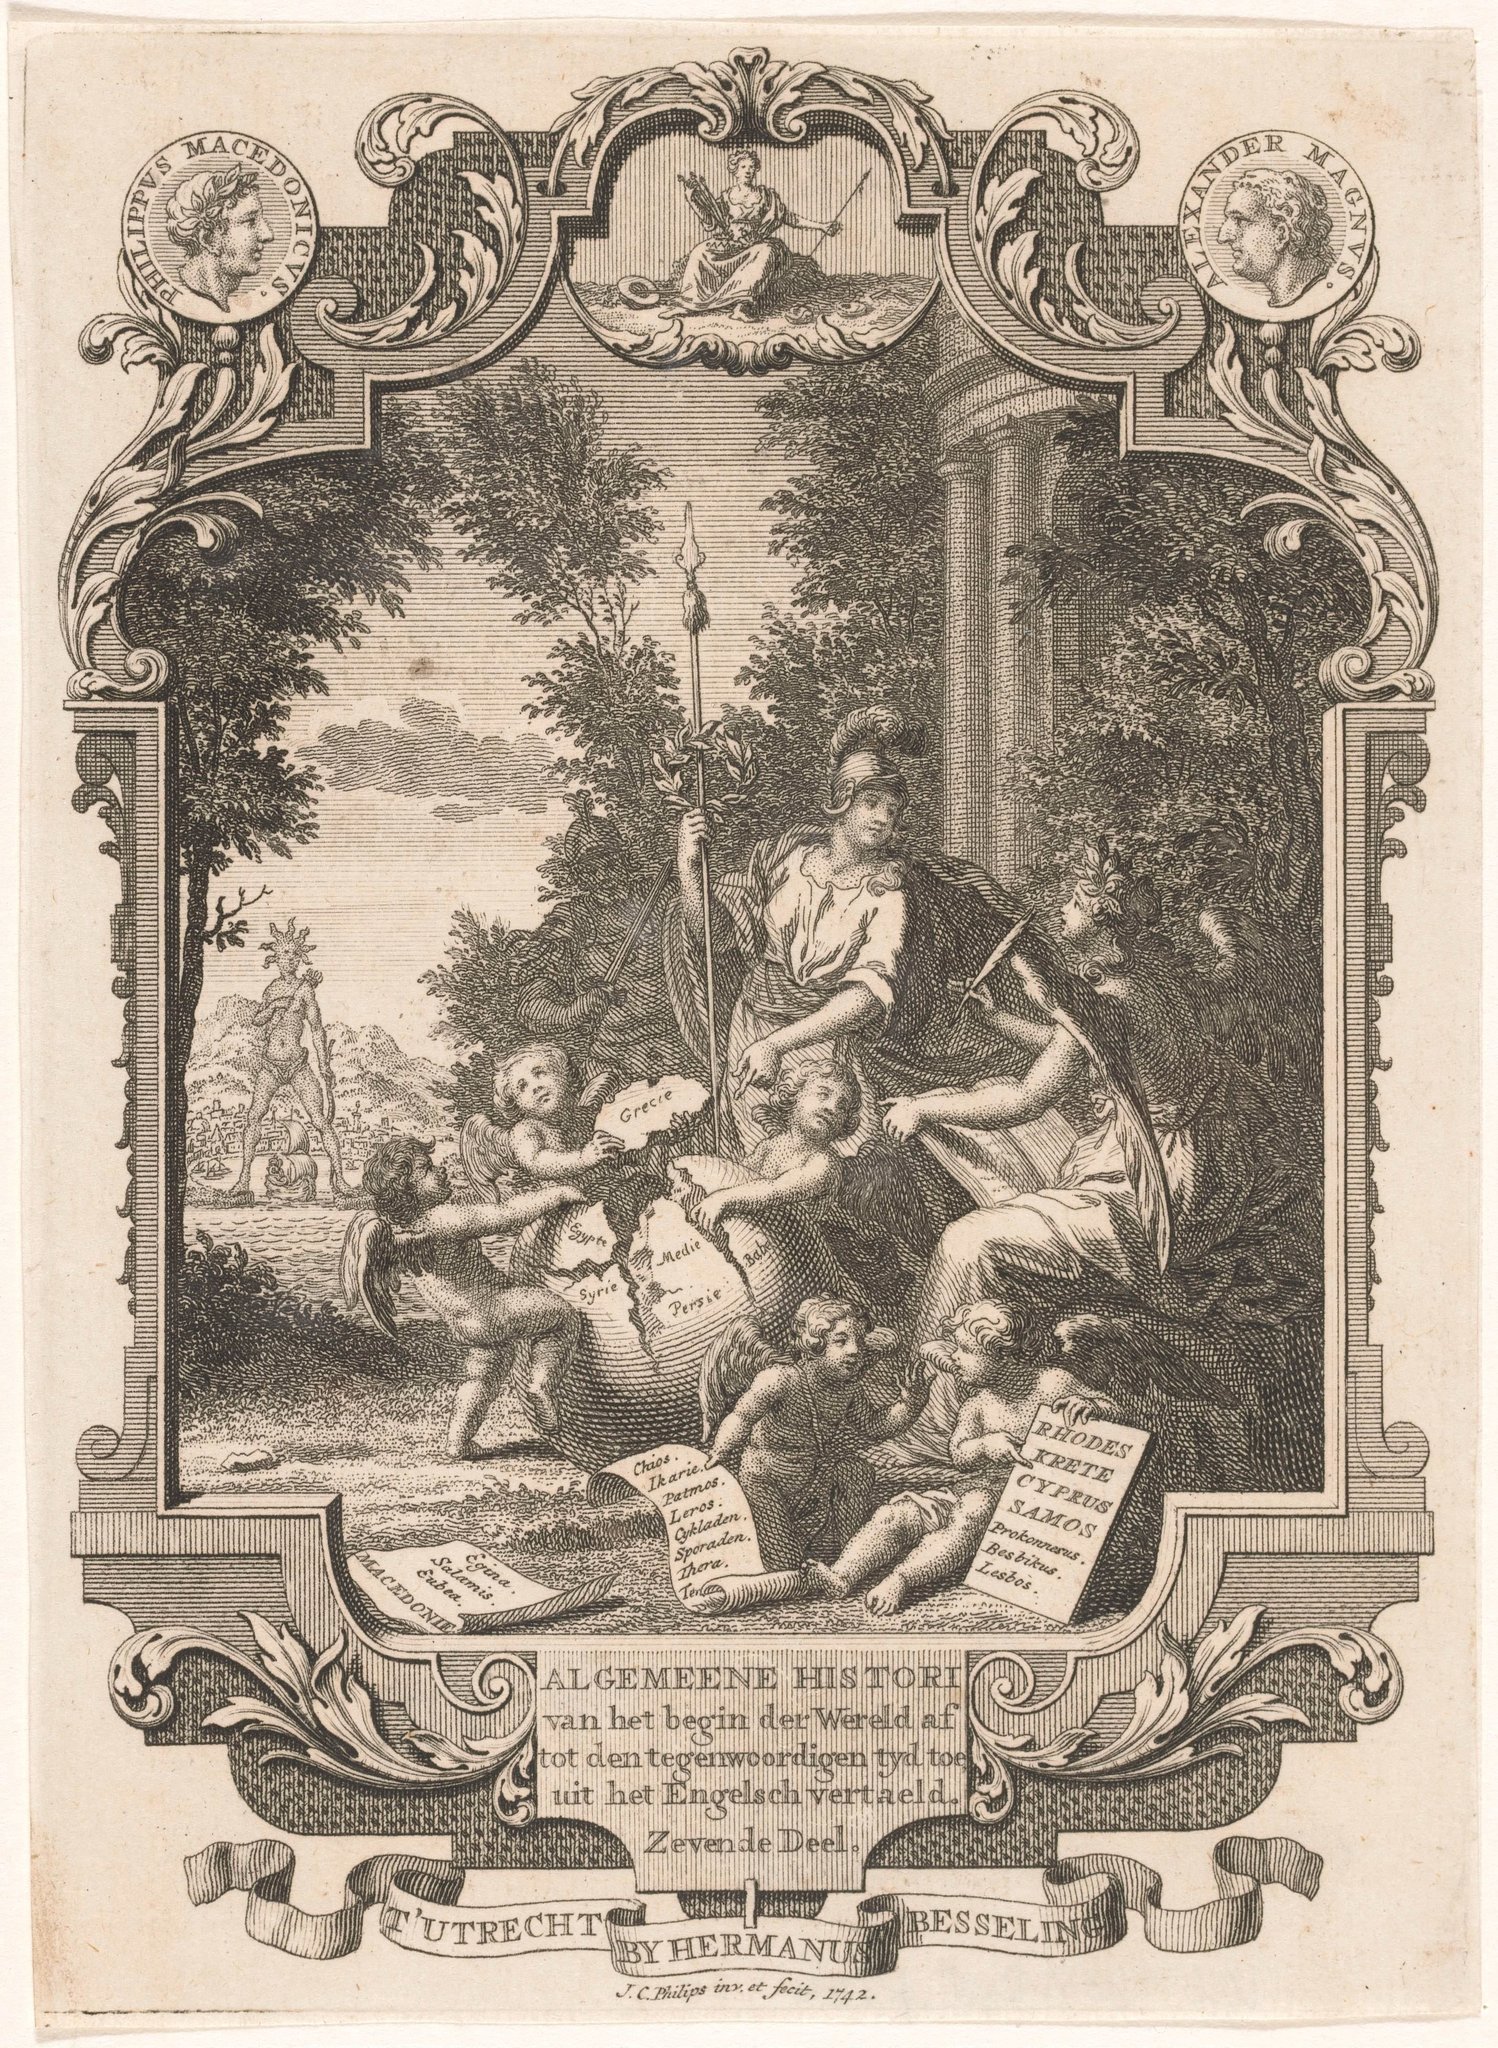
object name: titelblad, titelpagina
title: Cartouche met allegorie op de geschiedenis van Griekenland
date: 1742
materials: paper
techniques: engraving, etching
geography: utrecht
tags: (story of) minerva (pallas, athena), 'historia'; 'historia' (ripa), colossus of rhodes (wonder of the world)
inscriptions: collector's mark: Lugt 2228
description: Titelpagina voor: Westerbaen, Kornelis. Algemeene histori van het begin der Wereld af tot den tegenwoordigen tyd toe, Zevende Deel. Utrecht: Besseling, Hermanus, 1742. Prent afkomstig uit een plakalbum met titelprenten, ornamenten etc. op blauw papier in 1983 uit elkaar gehaald. Volgens een notitie op verso zat de prent op p. 106 van dit album.